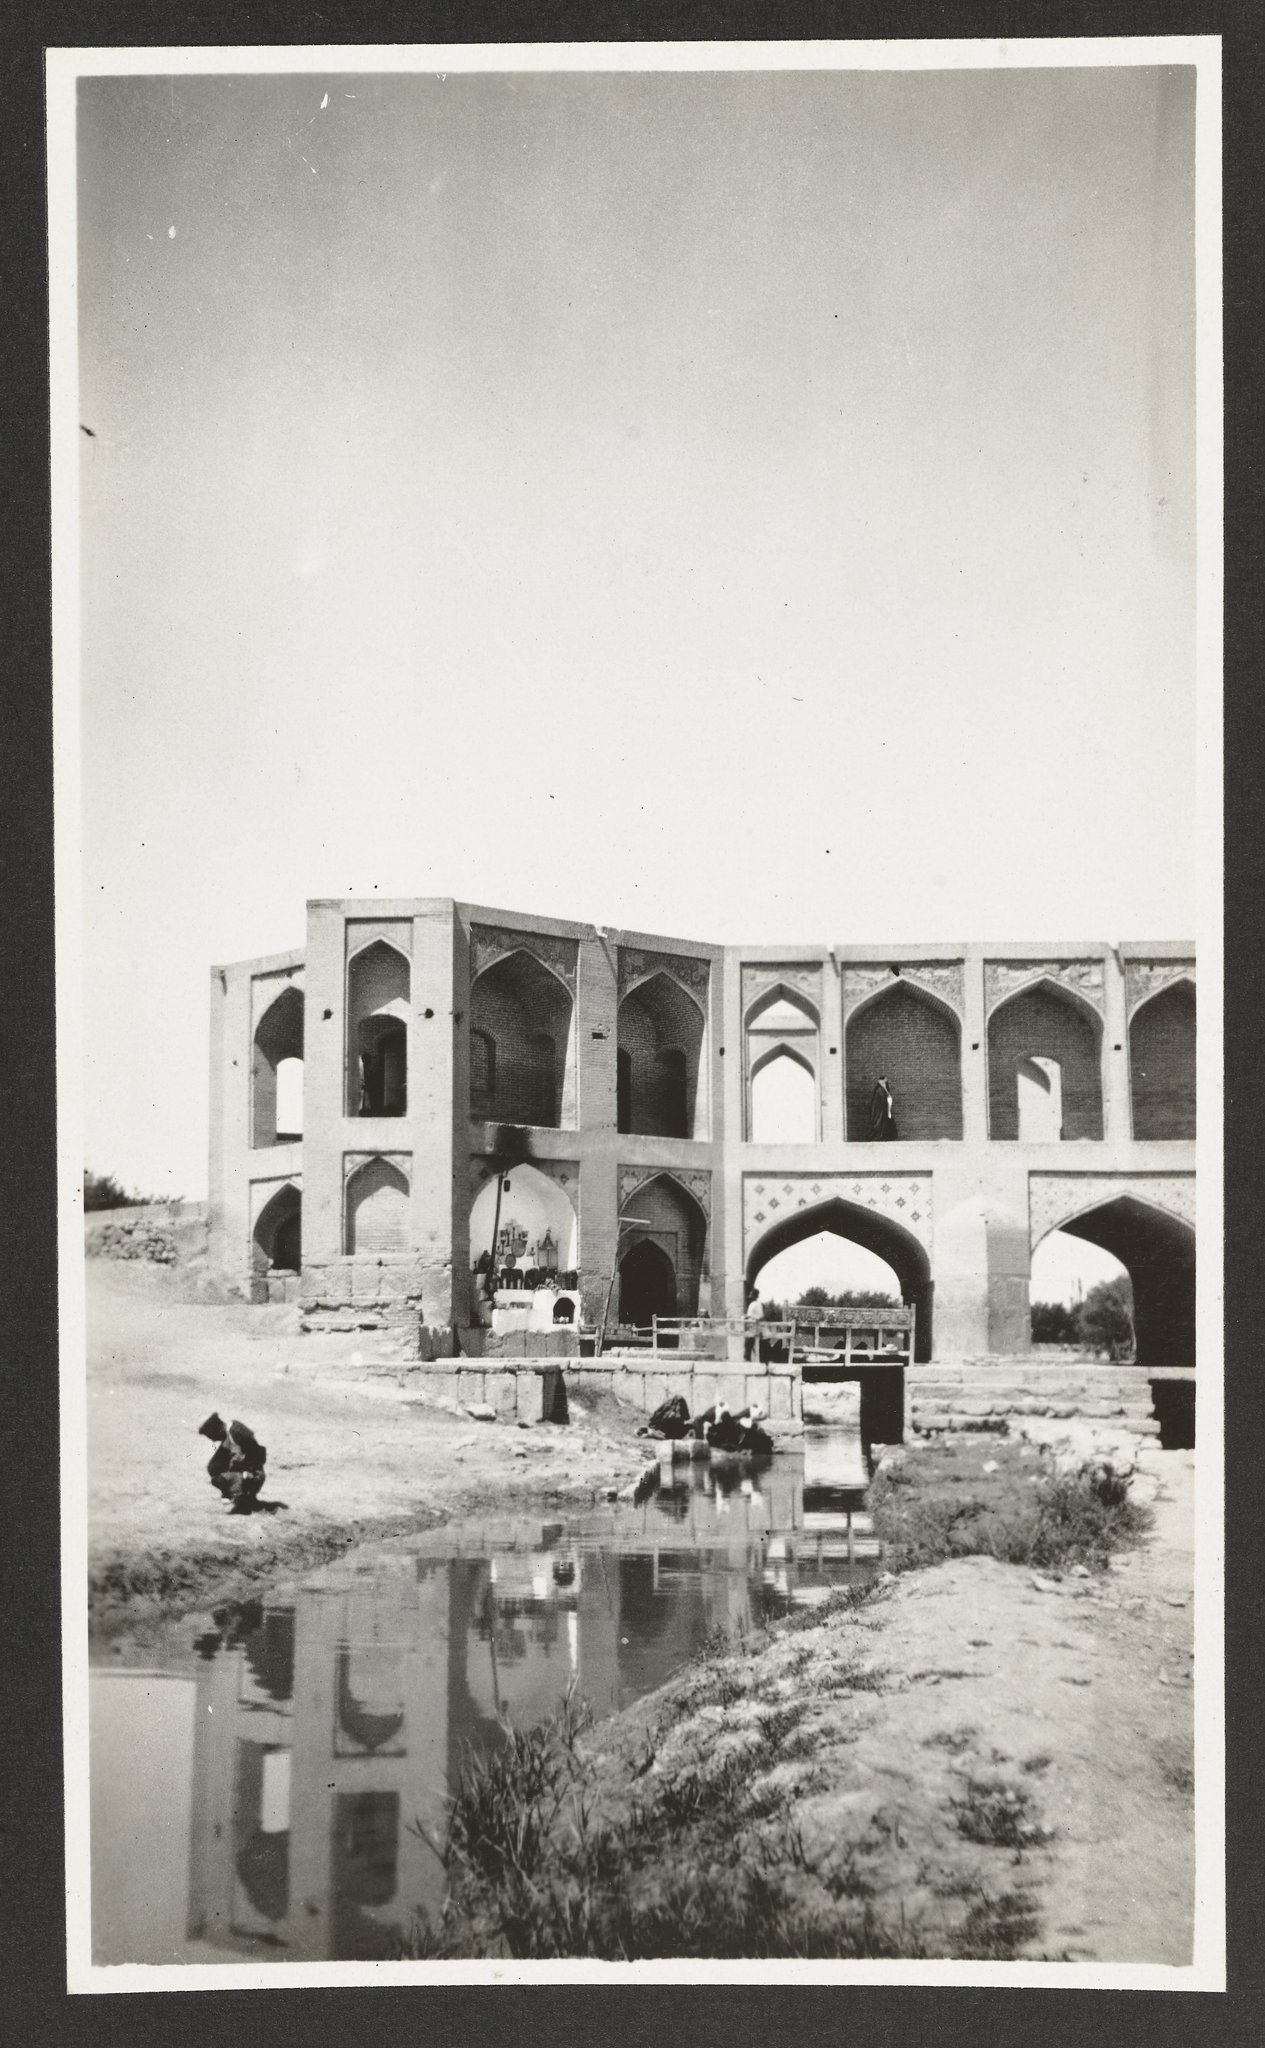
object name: photograph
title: Gedeelte van de brug over Zendeh Rud, Isfahan, Perzië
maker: a.g.a. van eelde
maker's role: engineer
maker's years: 1862-1950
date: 1925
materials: cardboard, paper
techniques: gelatin silver print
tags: iran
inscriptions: number: ‘26.’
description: Titel op object afkomstig uit inventaris (Verklaring der Photo's) behorend bij het album.